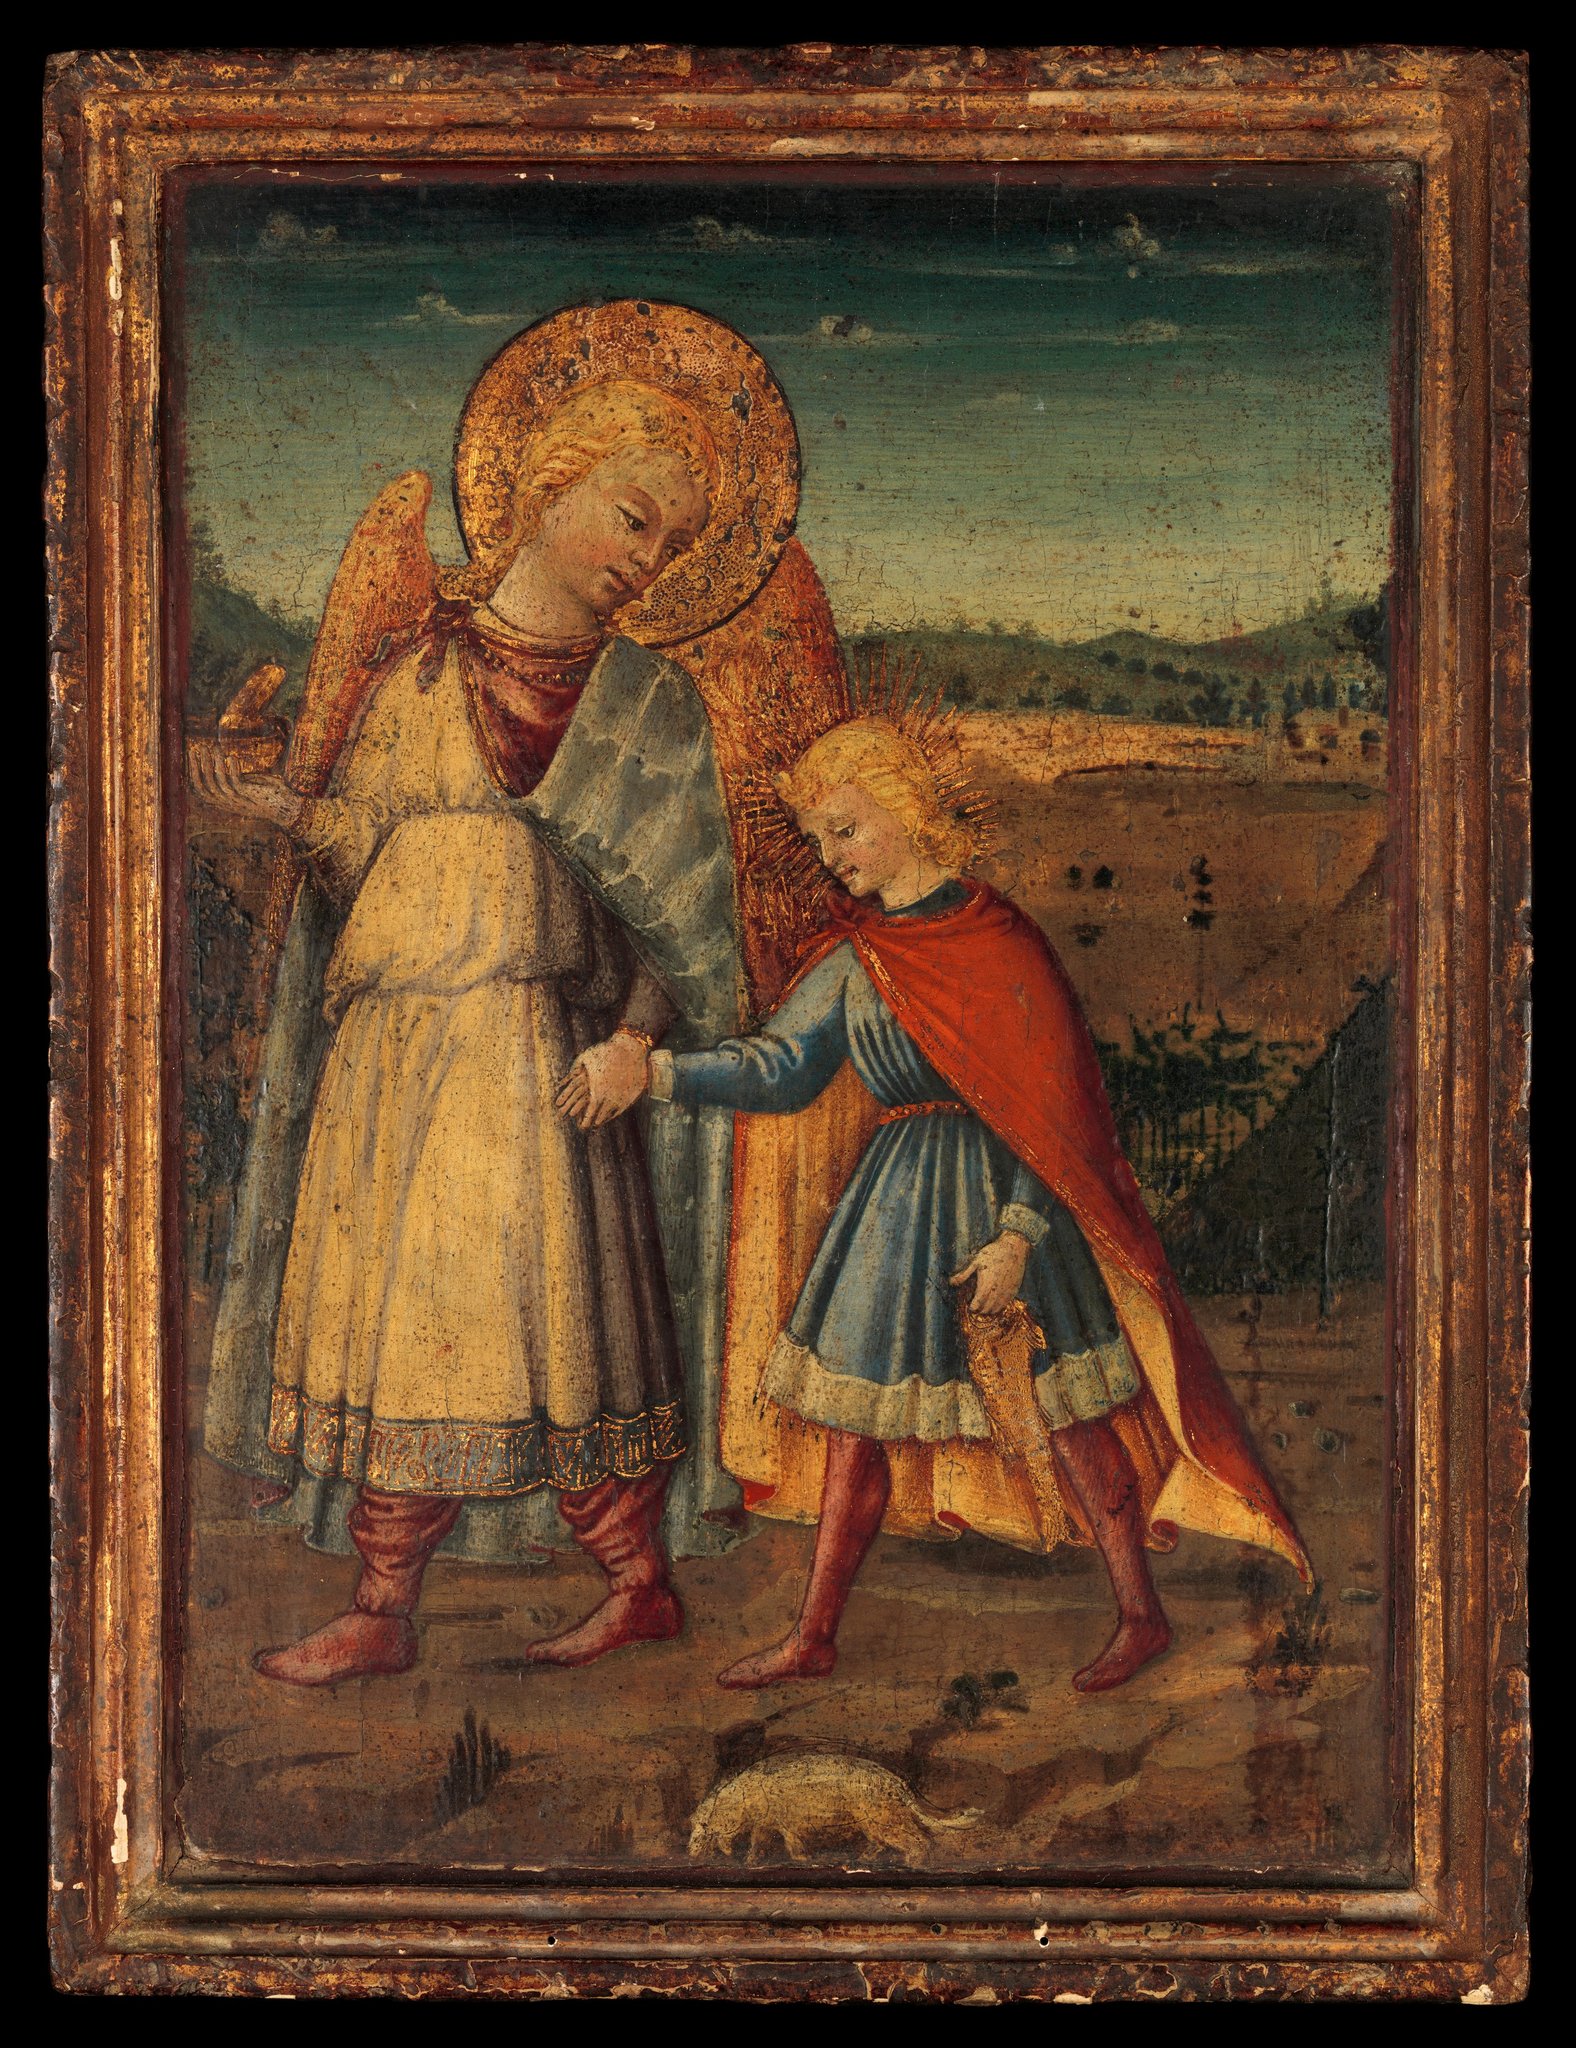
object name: painting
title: The Archangel Raphael and Tobias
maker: neri di bicci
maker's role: artist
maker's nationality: italian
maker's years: 1419-1491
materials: gold, paint, wood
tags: boys,angels